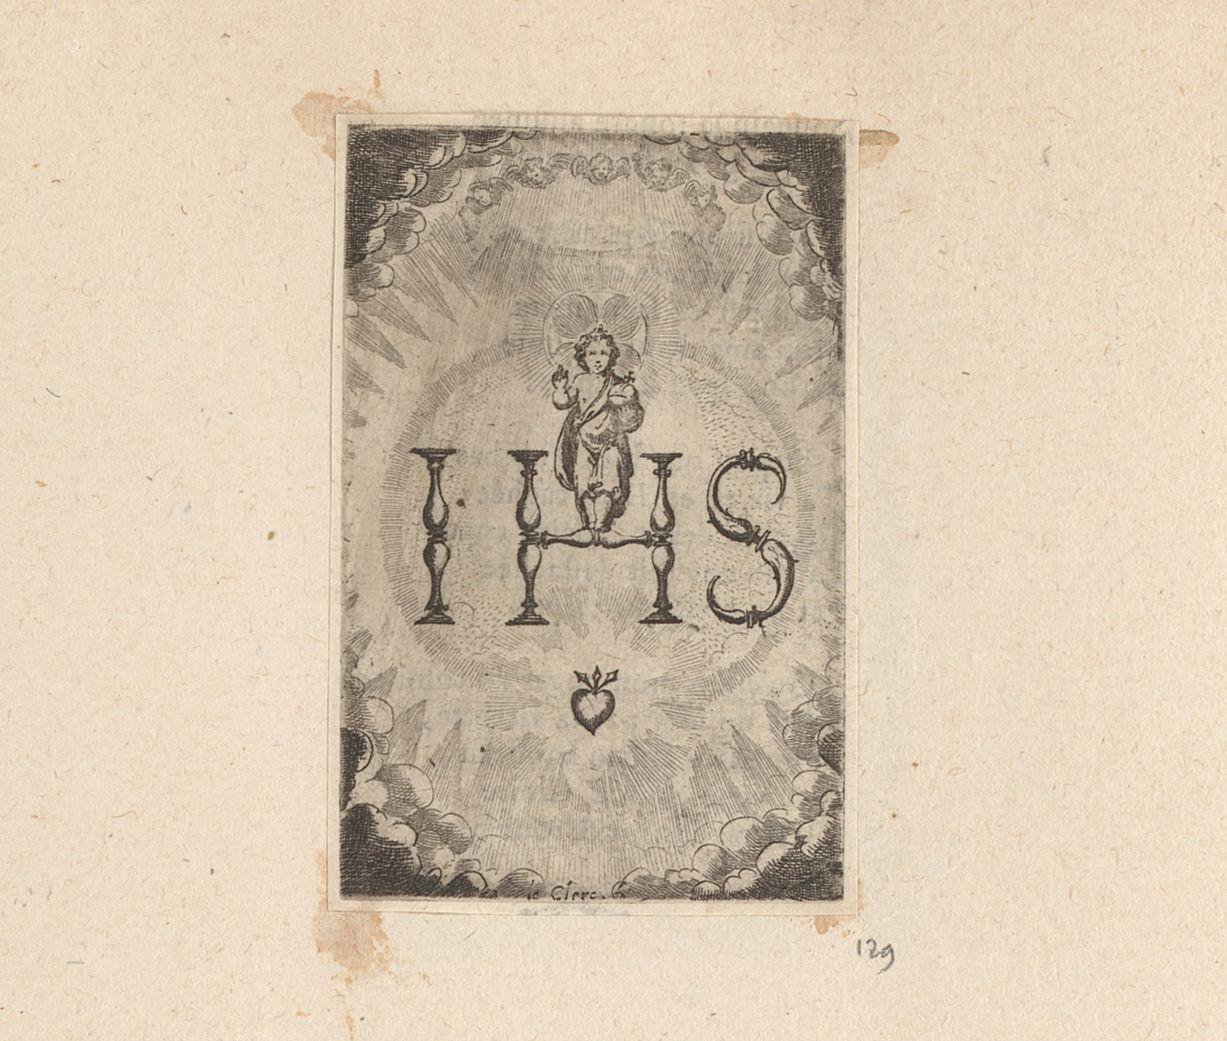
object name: print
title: Tableaux ou sont represétés la Passion de N.S. Jesus Christ (...)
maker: sébastien leclerc (i)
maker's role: print maker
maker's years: 1637-1714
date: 1665-1685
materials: paper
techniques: etching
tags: 'salvator mundi', making a blessing gesture; an orb in his hand or at his feet - dd - christ beardless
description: Prent uit een serie met 35 prenten met voorstellingen van gebruiken van priesters tijdens de mis. De serie wordt ook wel 'La Première Messe' genoemd.